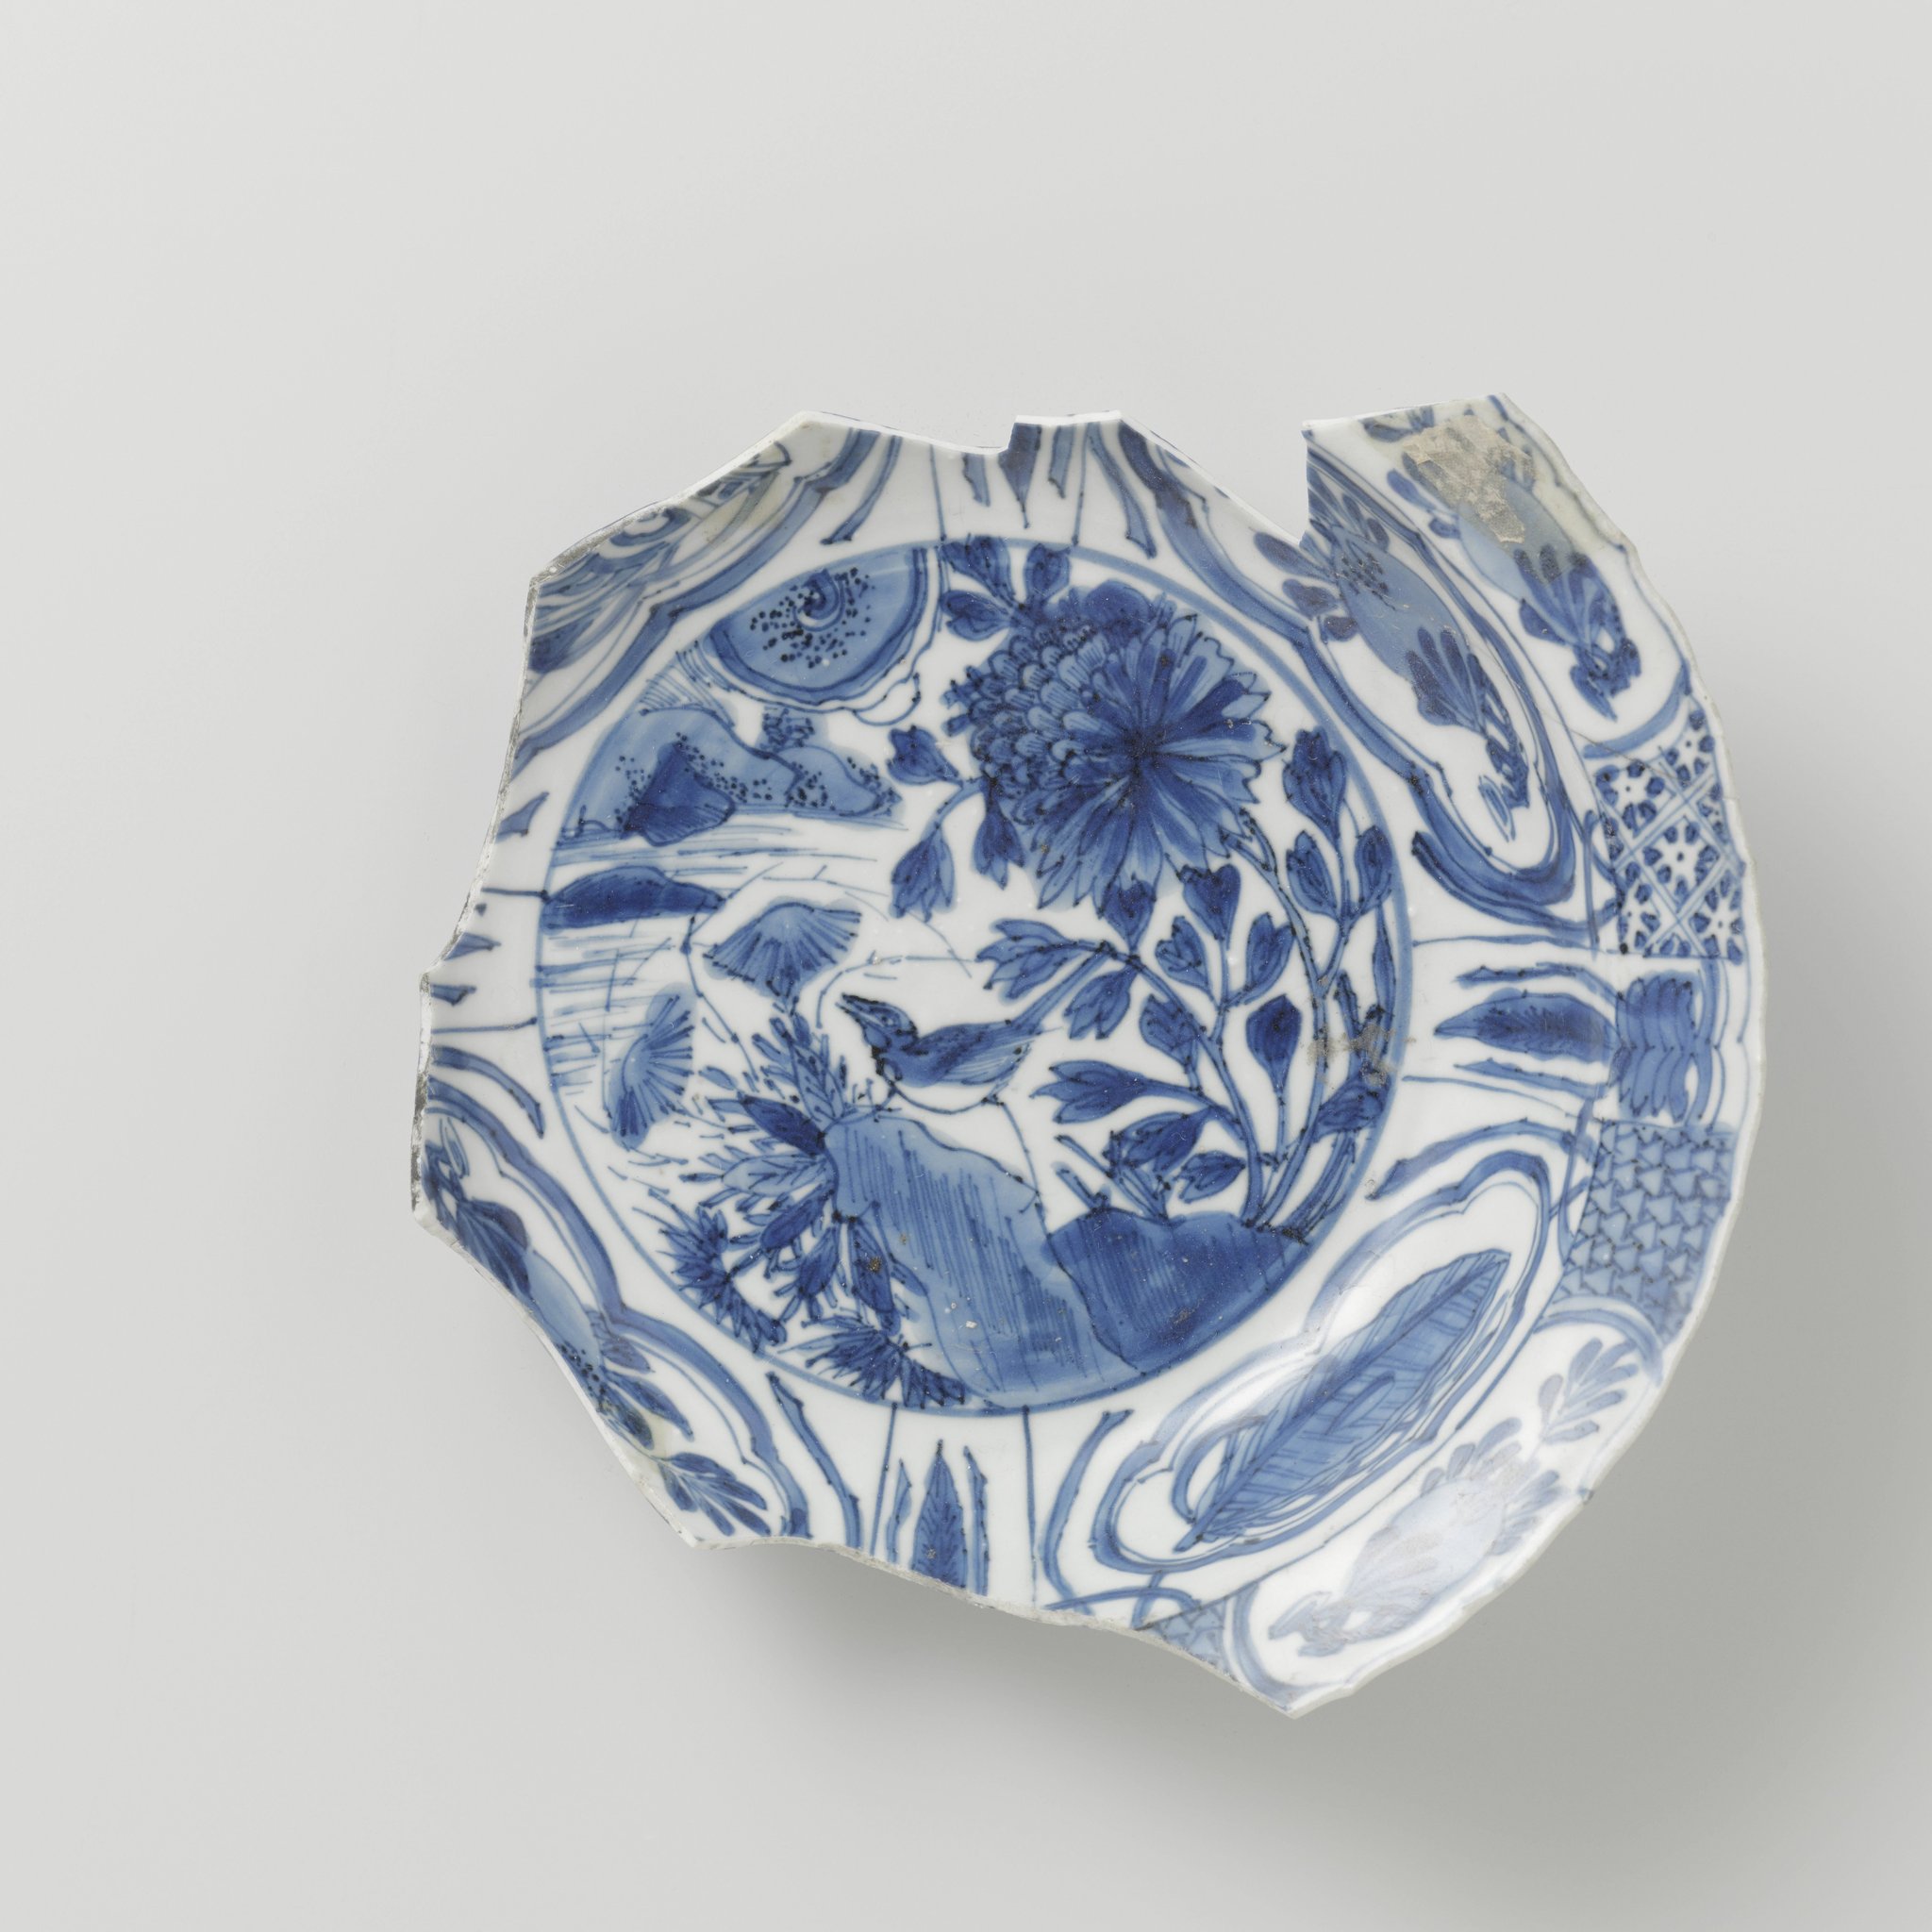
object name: deep dish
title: Diep bord uit V.O.C.-schip de 'Witte Leeuw'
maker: Anonymous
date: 1613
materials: bone china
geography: jingdezhen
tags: plants and herbs: peony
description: A bowl with a flattened rim. Cartouches with fruits enclosed by diaper patterns. A central decoration of bird on a rock and a peony. Panels decorated with peaches and symbols.